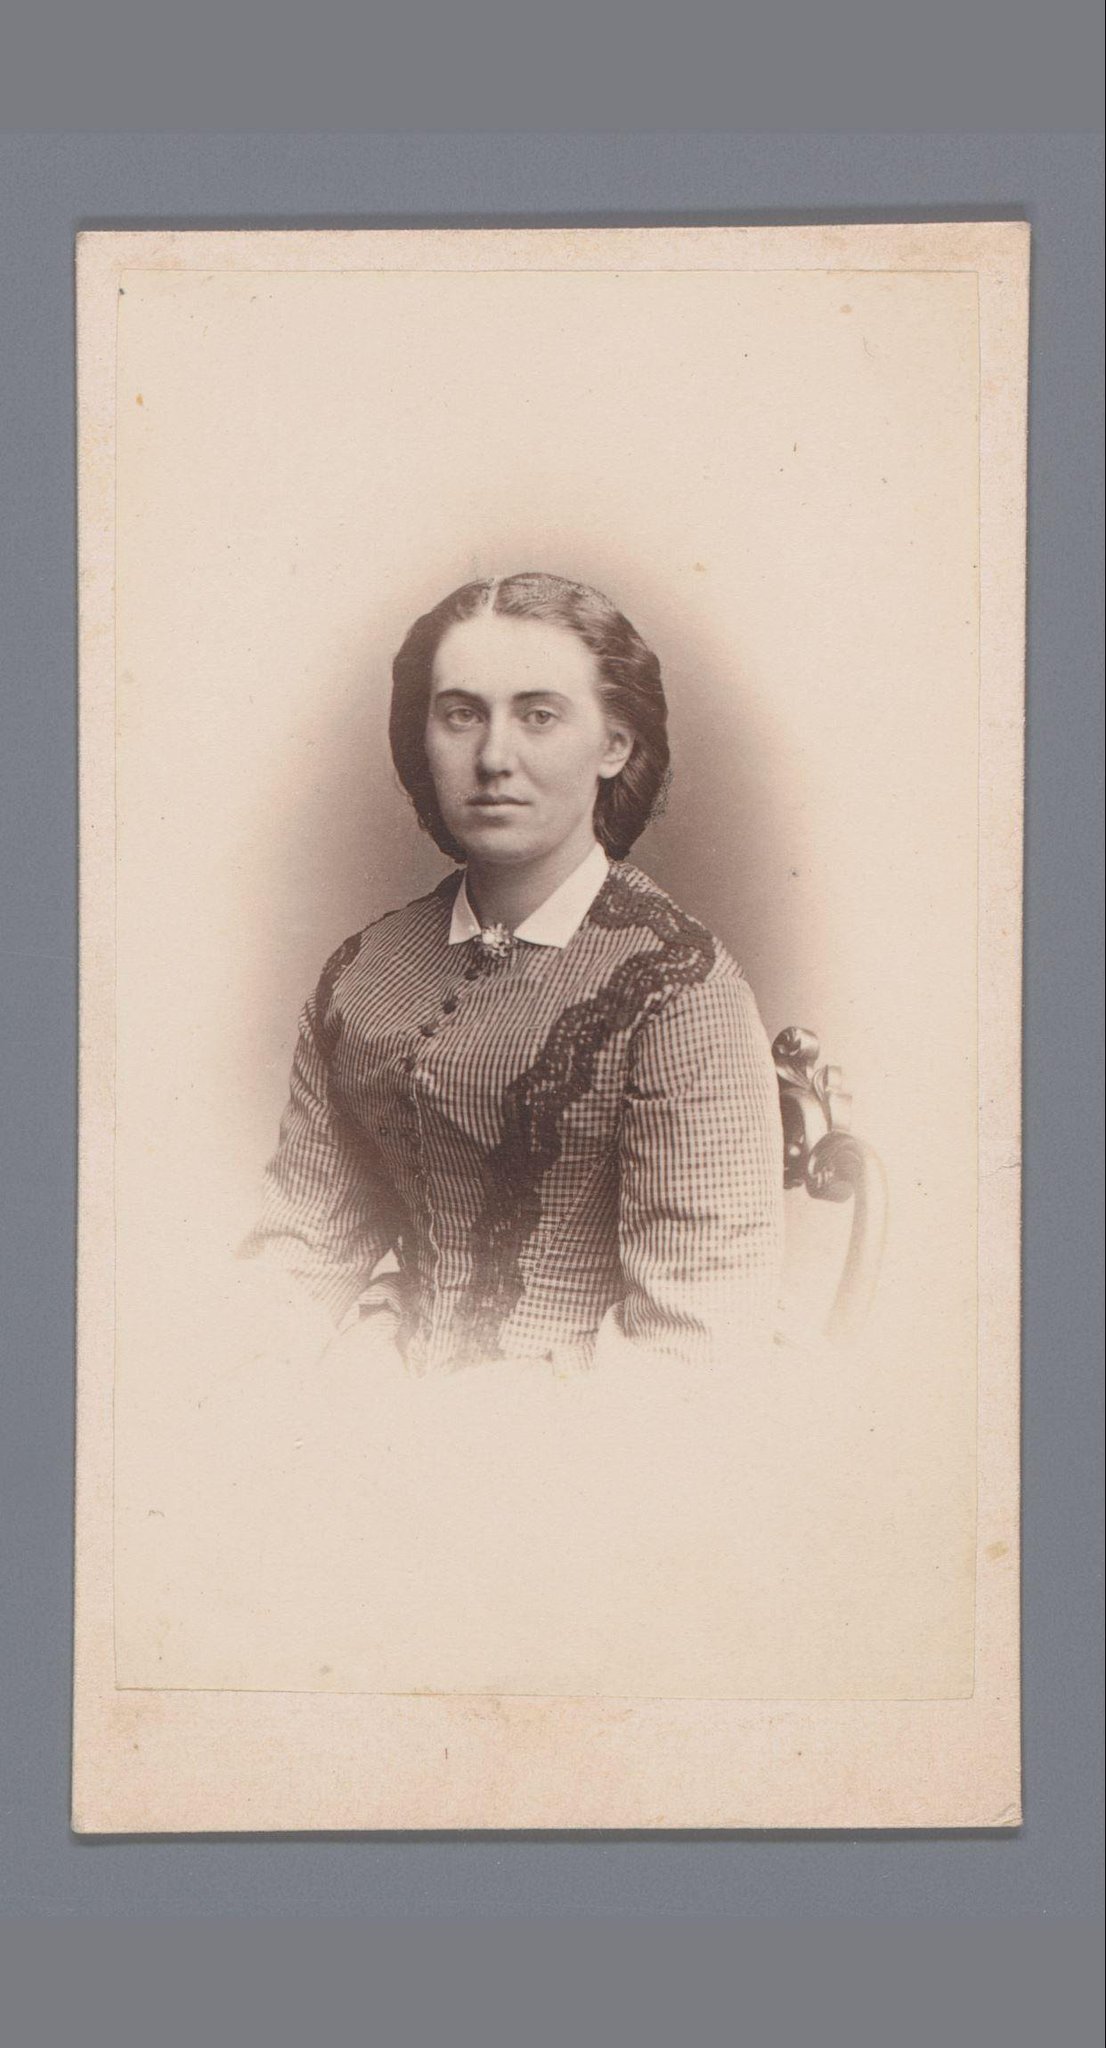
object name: photograph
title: Portret van een onbekende vrouw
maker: johannes jaeger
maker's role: fotograaf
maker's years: 1832-1908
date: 1863-1890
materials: cardboard, paper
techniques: albumen print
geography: stockholm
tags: historical persons - bb - woman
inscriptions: address: ‘Kongl. Hof-Fotograf/ Regeringsgatan No 11./ Hörnet af Herkulesgatan./ STOCKHOLM.’